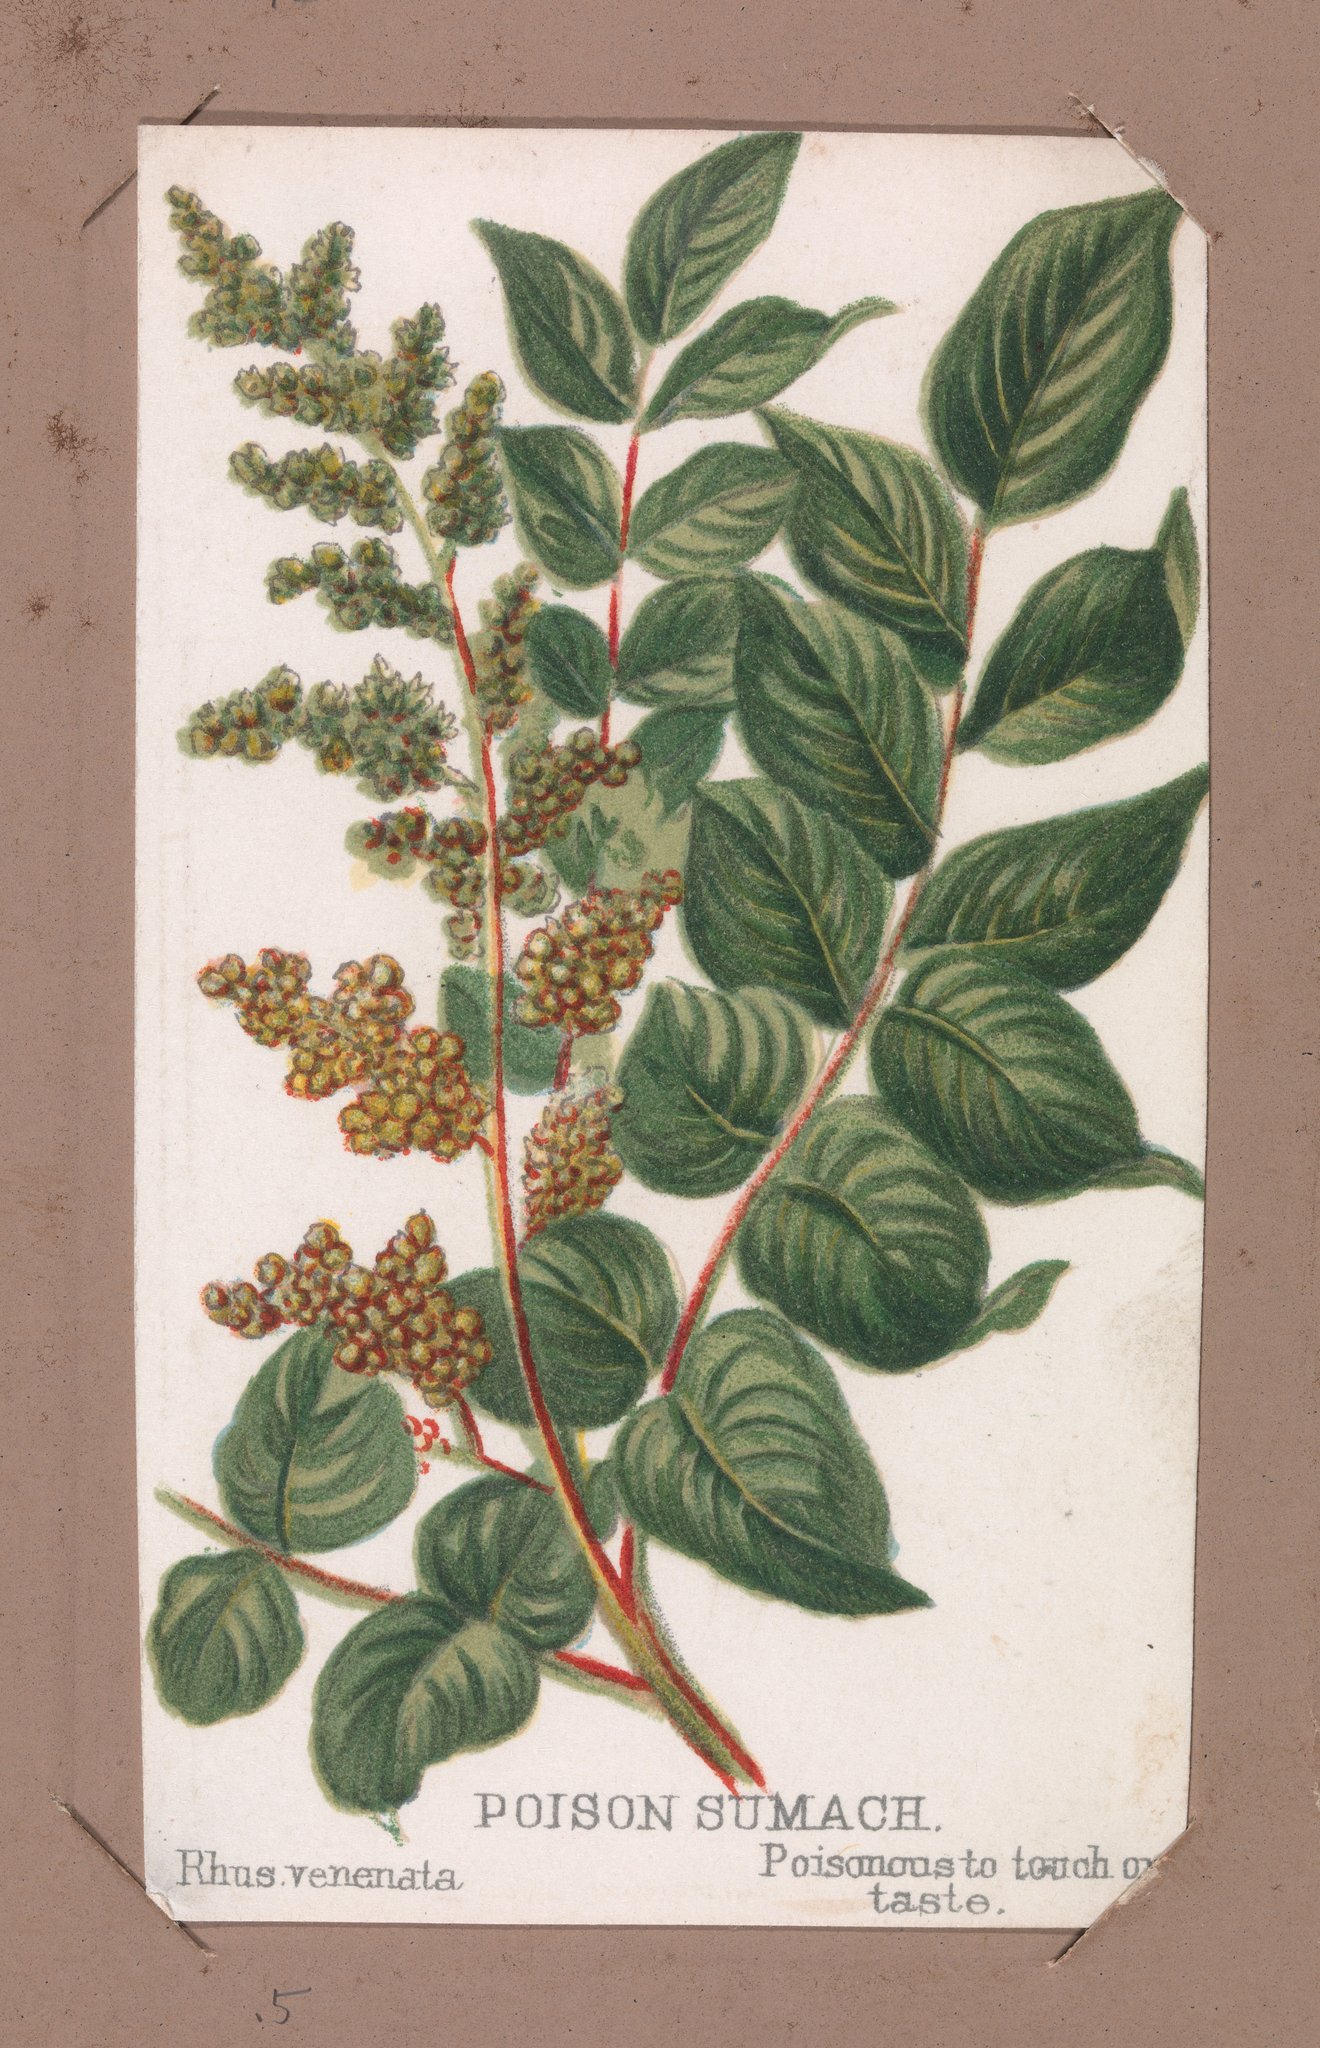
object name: album card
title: Poison Sumach from the Plants series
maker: louis prang & co.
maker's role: publisher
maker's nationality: american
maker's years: 1800-1950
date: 1862-1869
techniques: lithograph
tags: plants